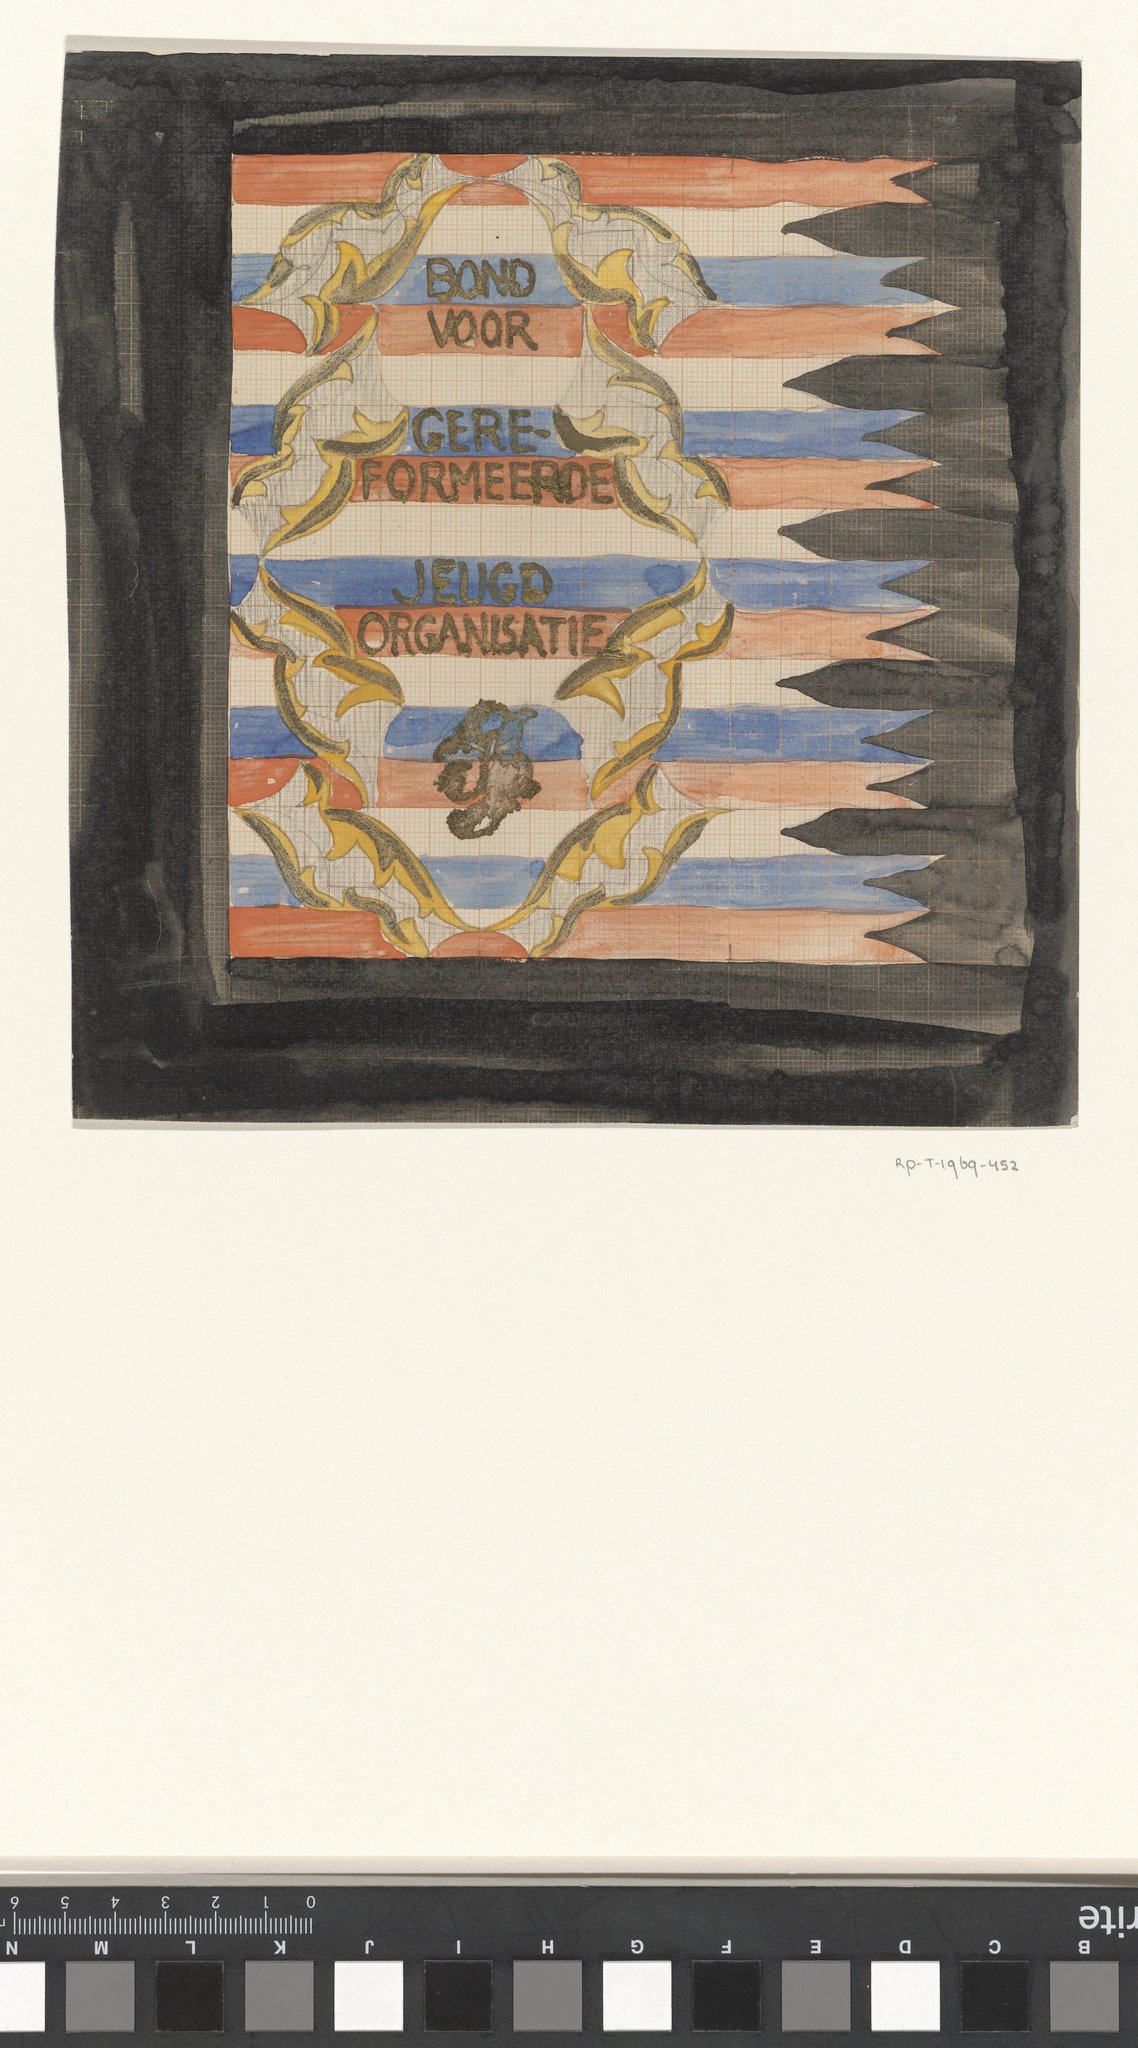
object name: design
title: Ontwerp voor vaandel van de Bond voor Gereformeerde Jeugdorganisatie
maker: carel adolph lion cachet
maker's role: draughtsman, print maker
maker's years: 1864-1945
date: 1874-1945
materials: paint, pencil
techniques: brush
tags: names of organizations, companies, trade unions, etc., banner, standard (as symbol of the state, etc.)